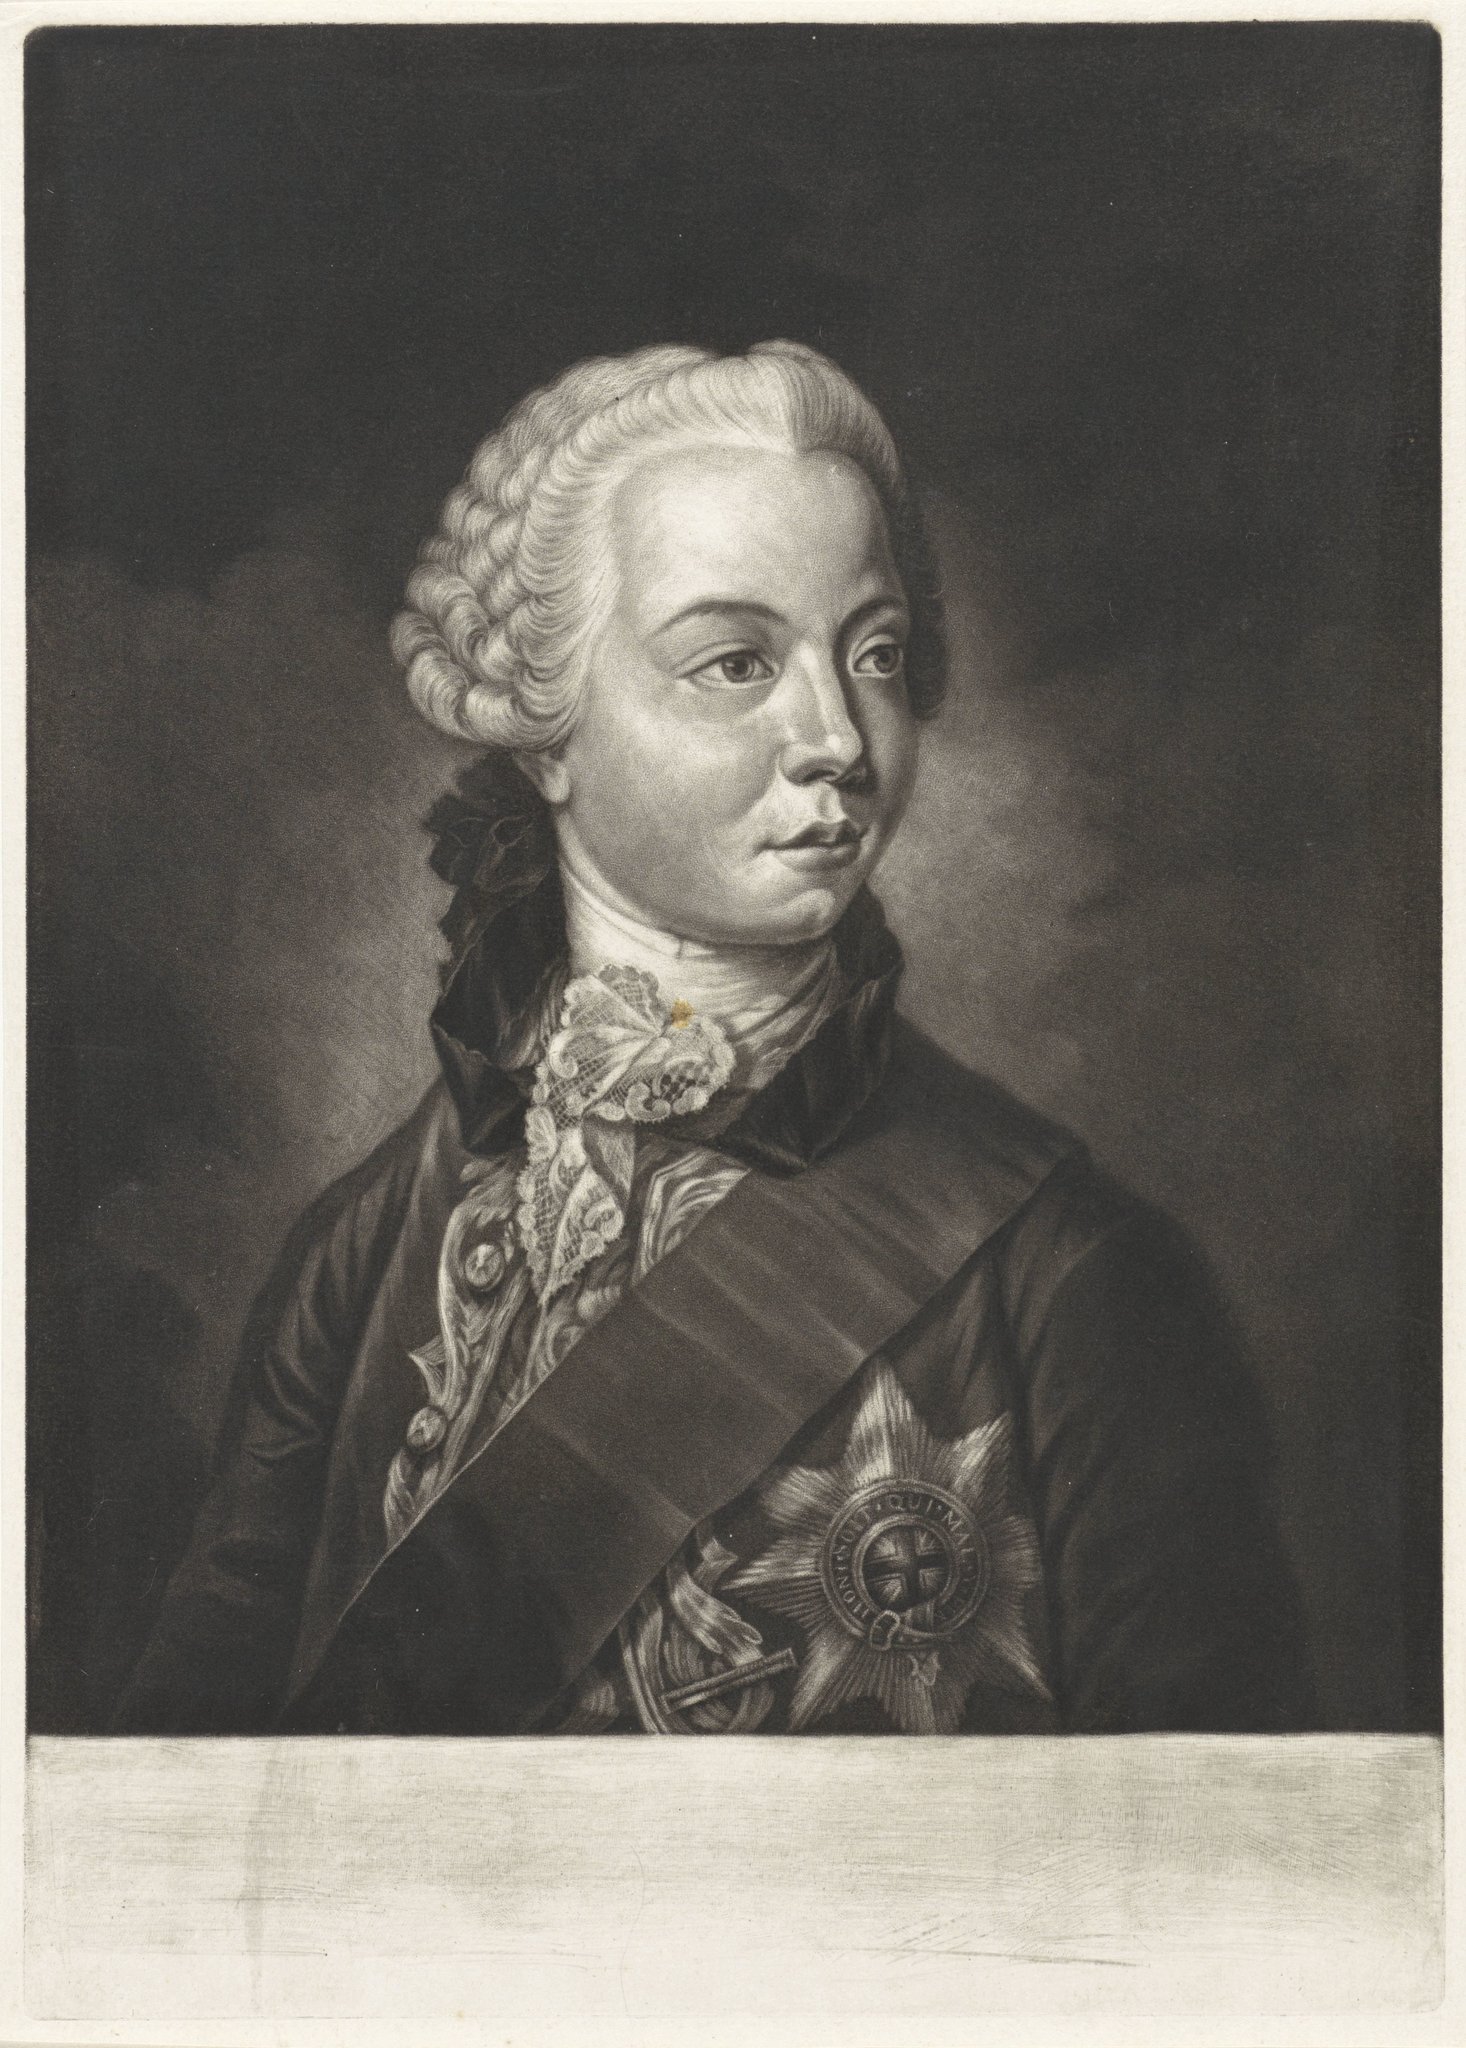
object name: print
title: Portret van Willem V, prins van Oranje-Nassau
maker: john greenwood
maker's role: auctioneer, draughtsman, print maker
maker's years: 1727-1792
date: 1755-1792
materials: paper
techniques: mezzotint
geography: the hague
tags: the hague, william v (prince of orange)